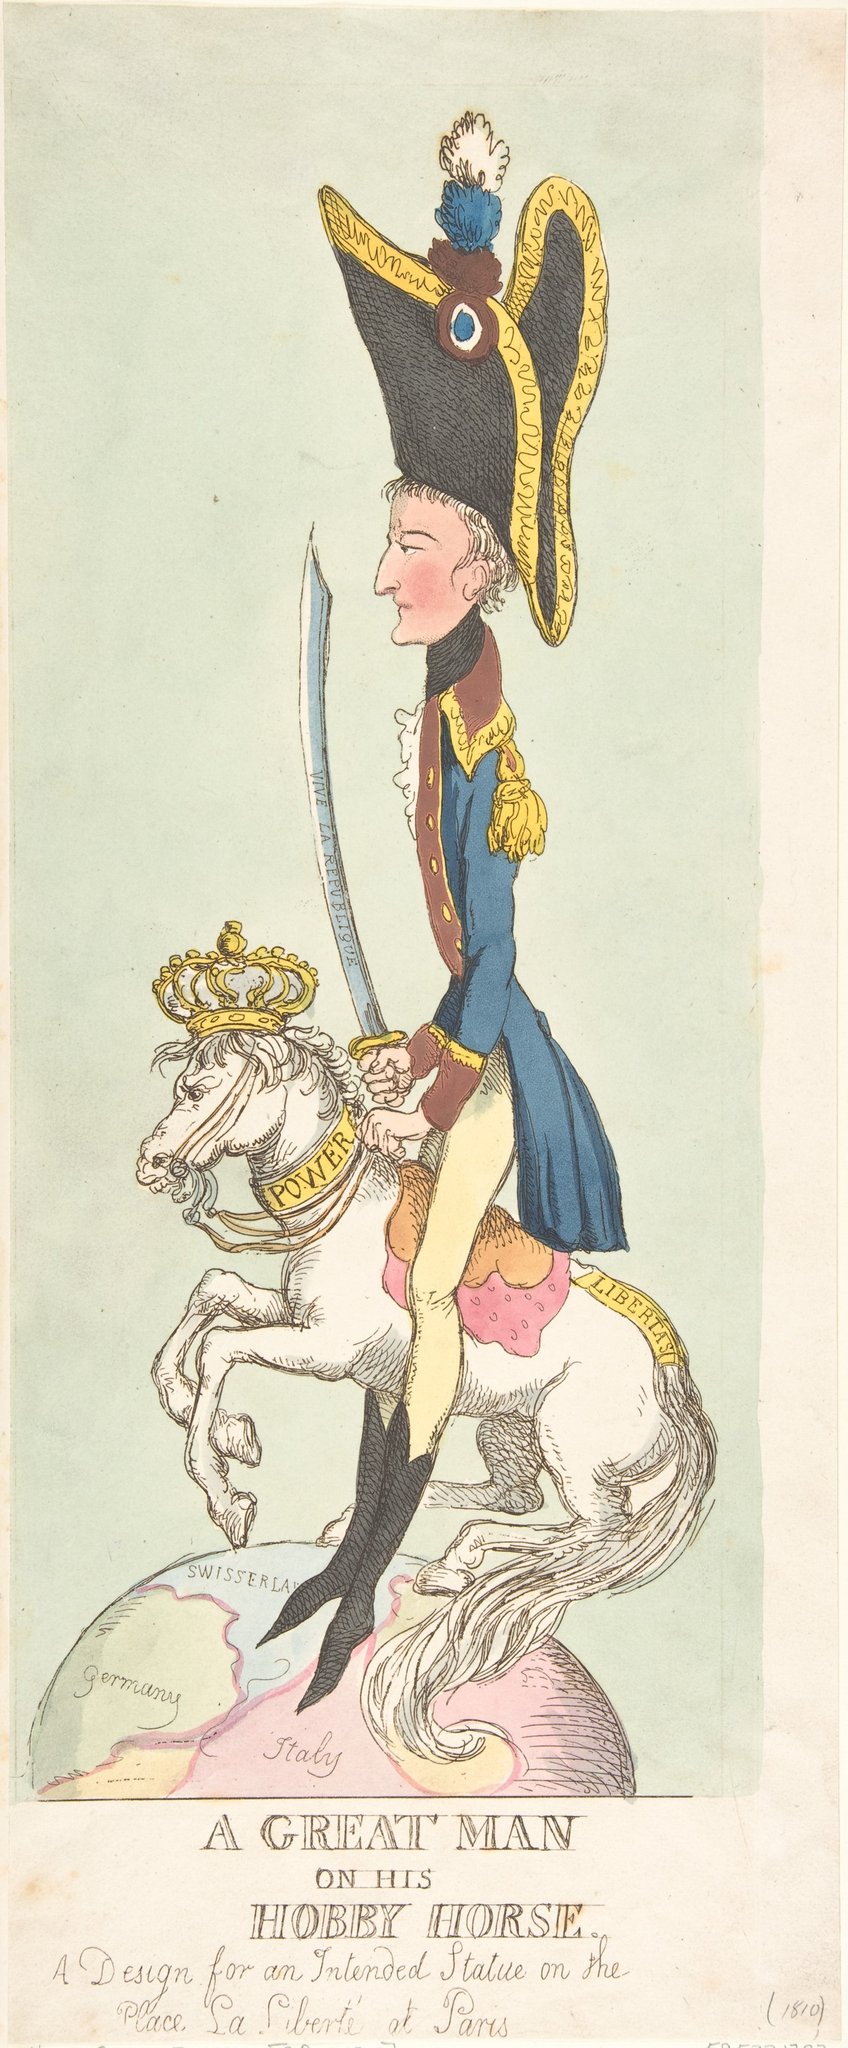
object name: print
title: A Great Man on His Hobby Horse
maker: thomas rowlandson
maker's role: artist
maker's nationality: british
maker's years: 1757-1827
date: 1803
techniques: etching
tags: satire,napoleon i,men,horses,politics